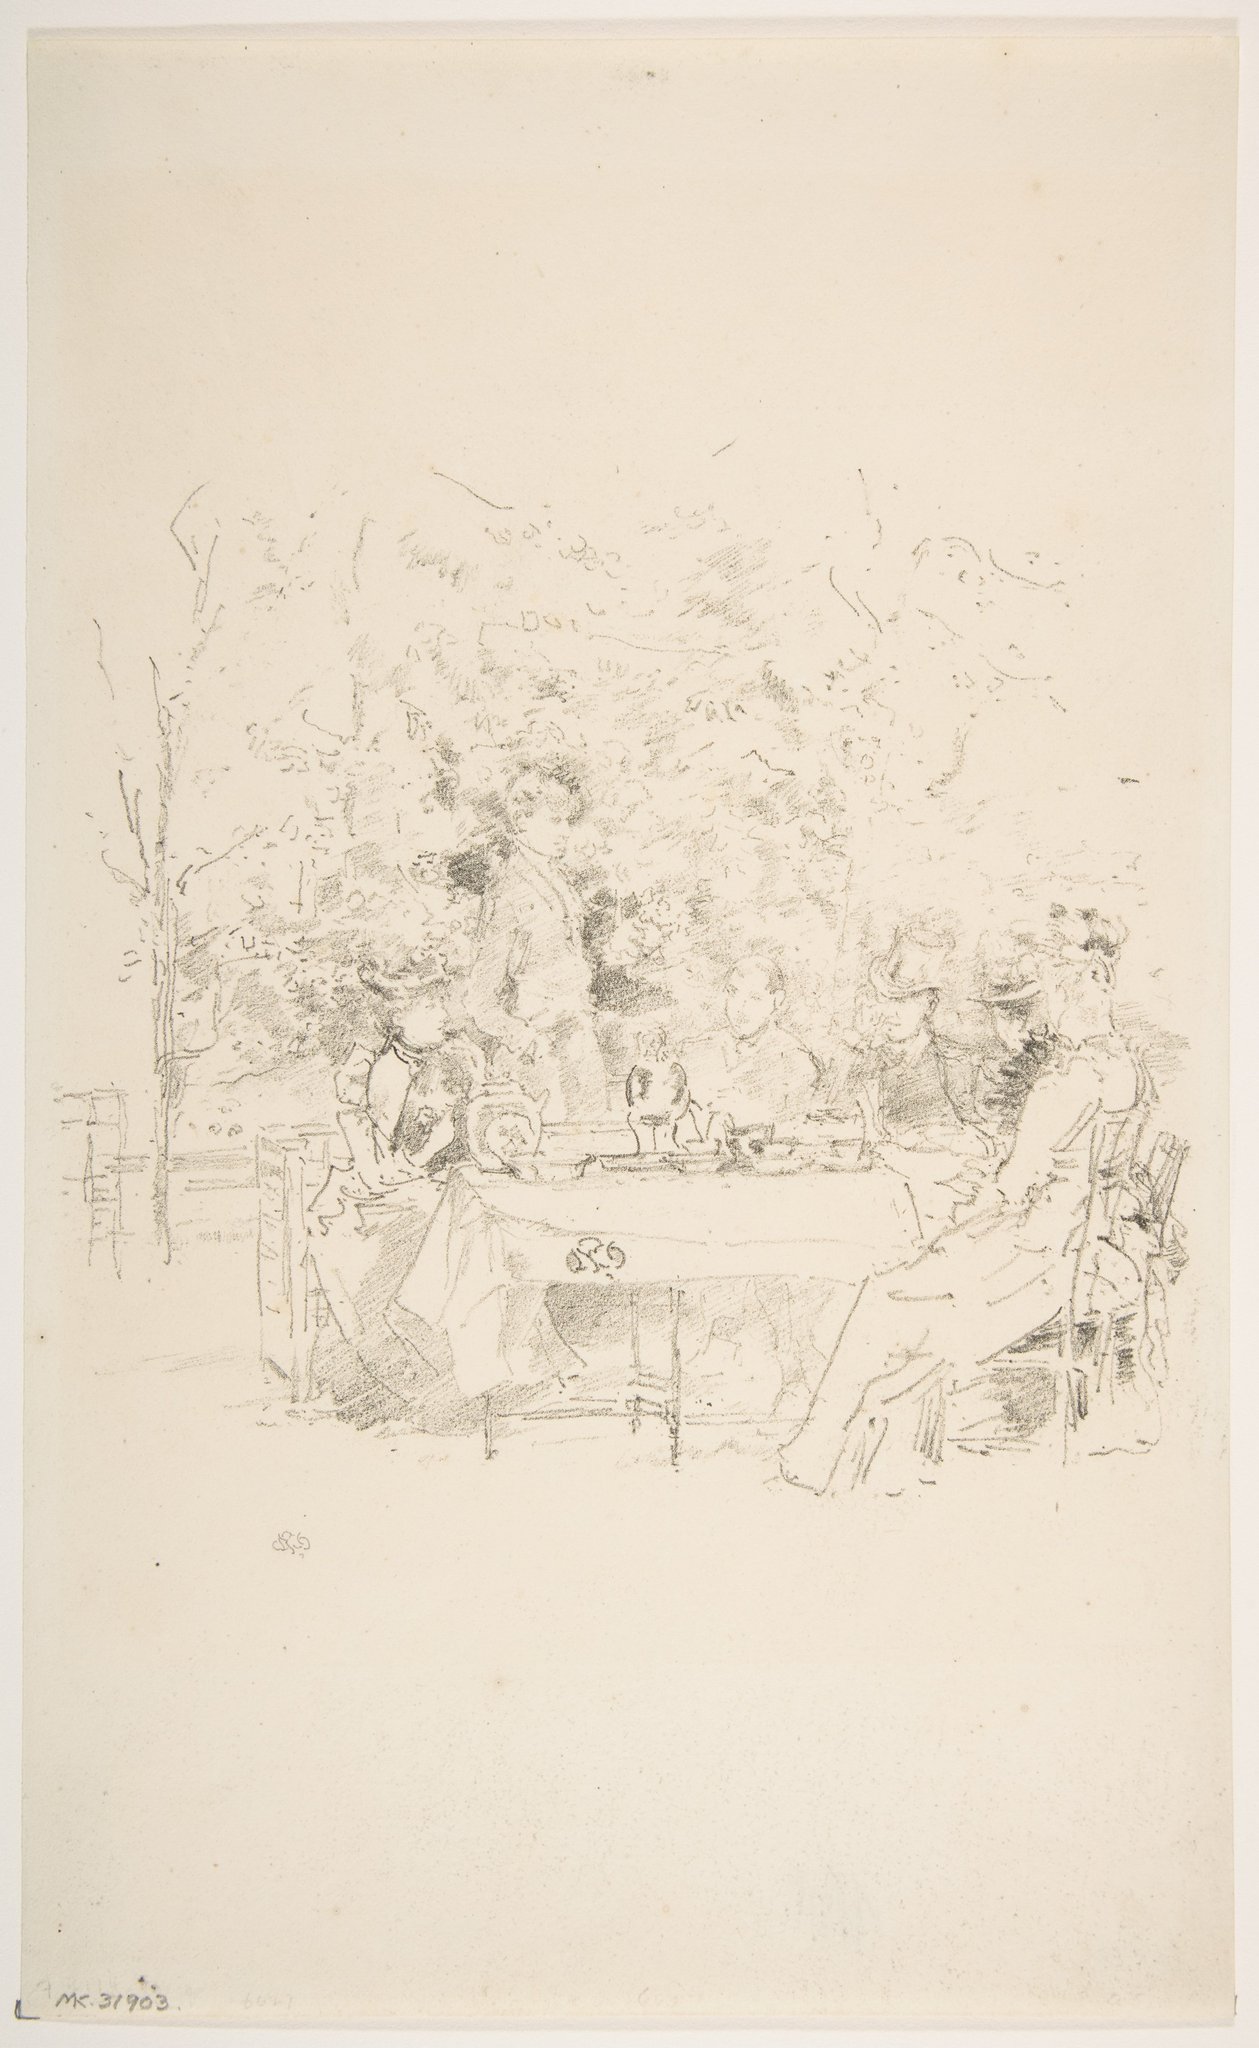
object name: print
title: The Garden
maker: james mcneill whistler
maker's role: artist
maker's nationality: american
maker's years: 1834-1903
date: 1891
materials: ink, paper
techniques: printing, lithography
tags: gardens,men,women,tea drinking,chairs